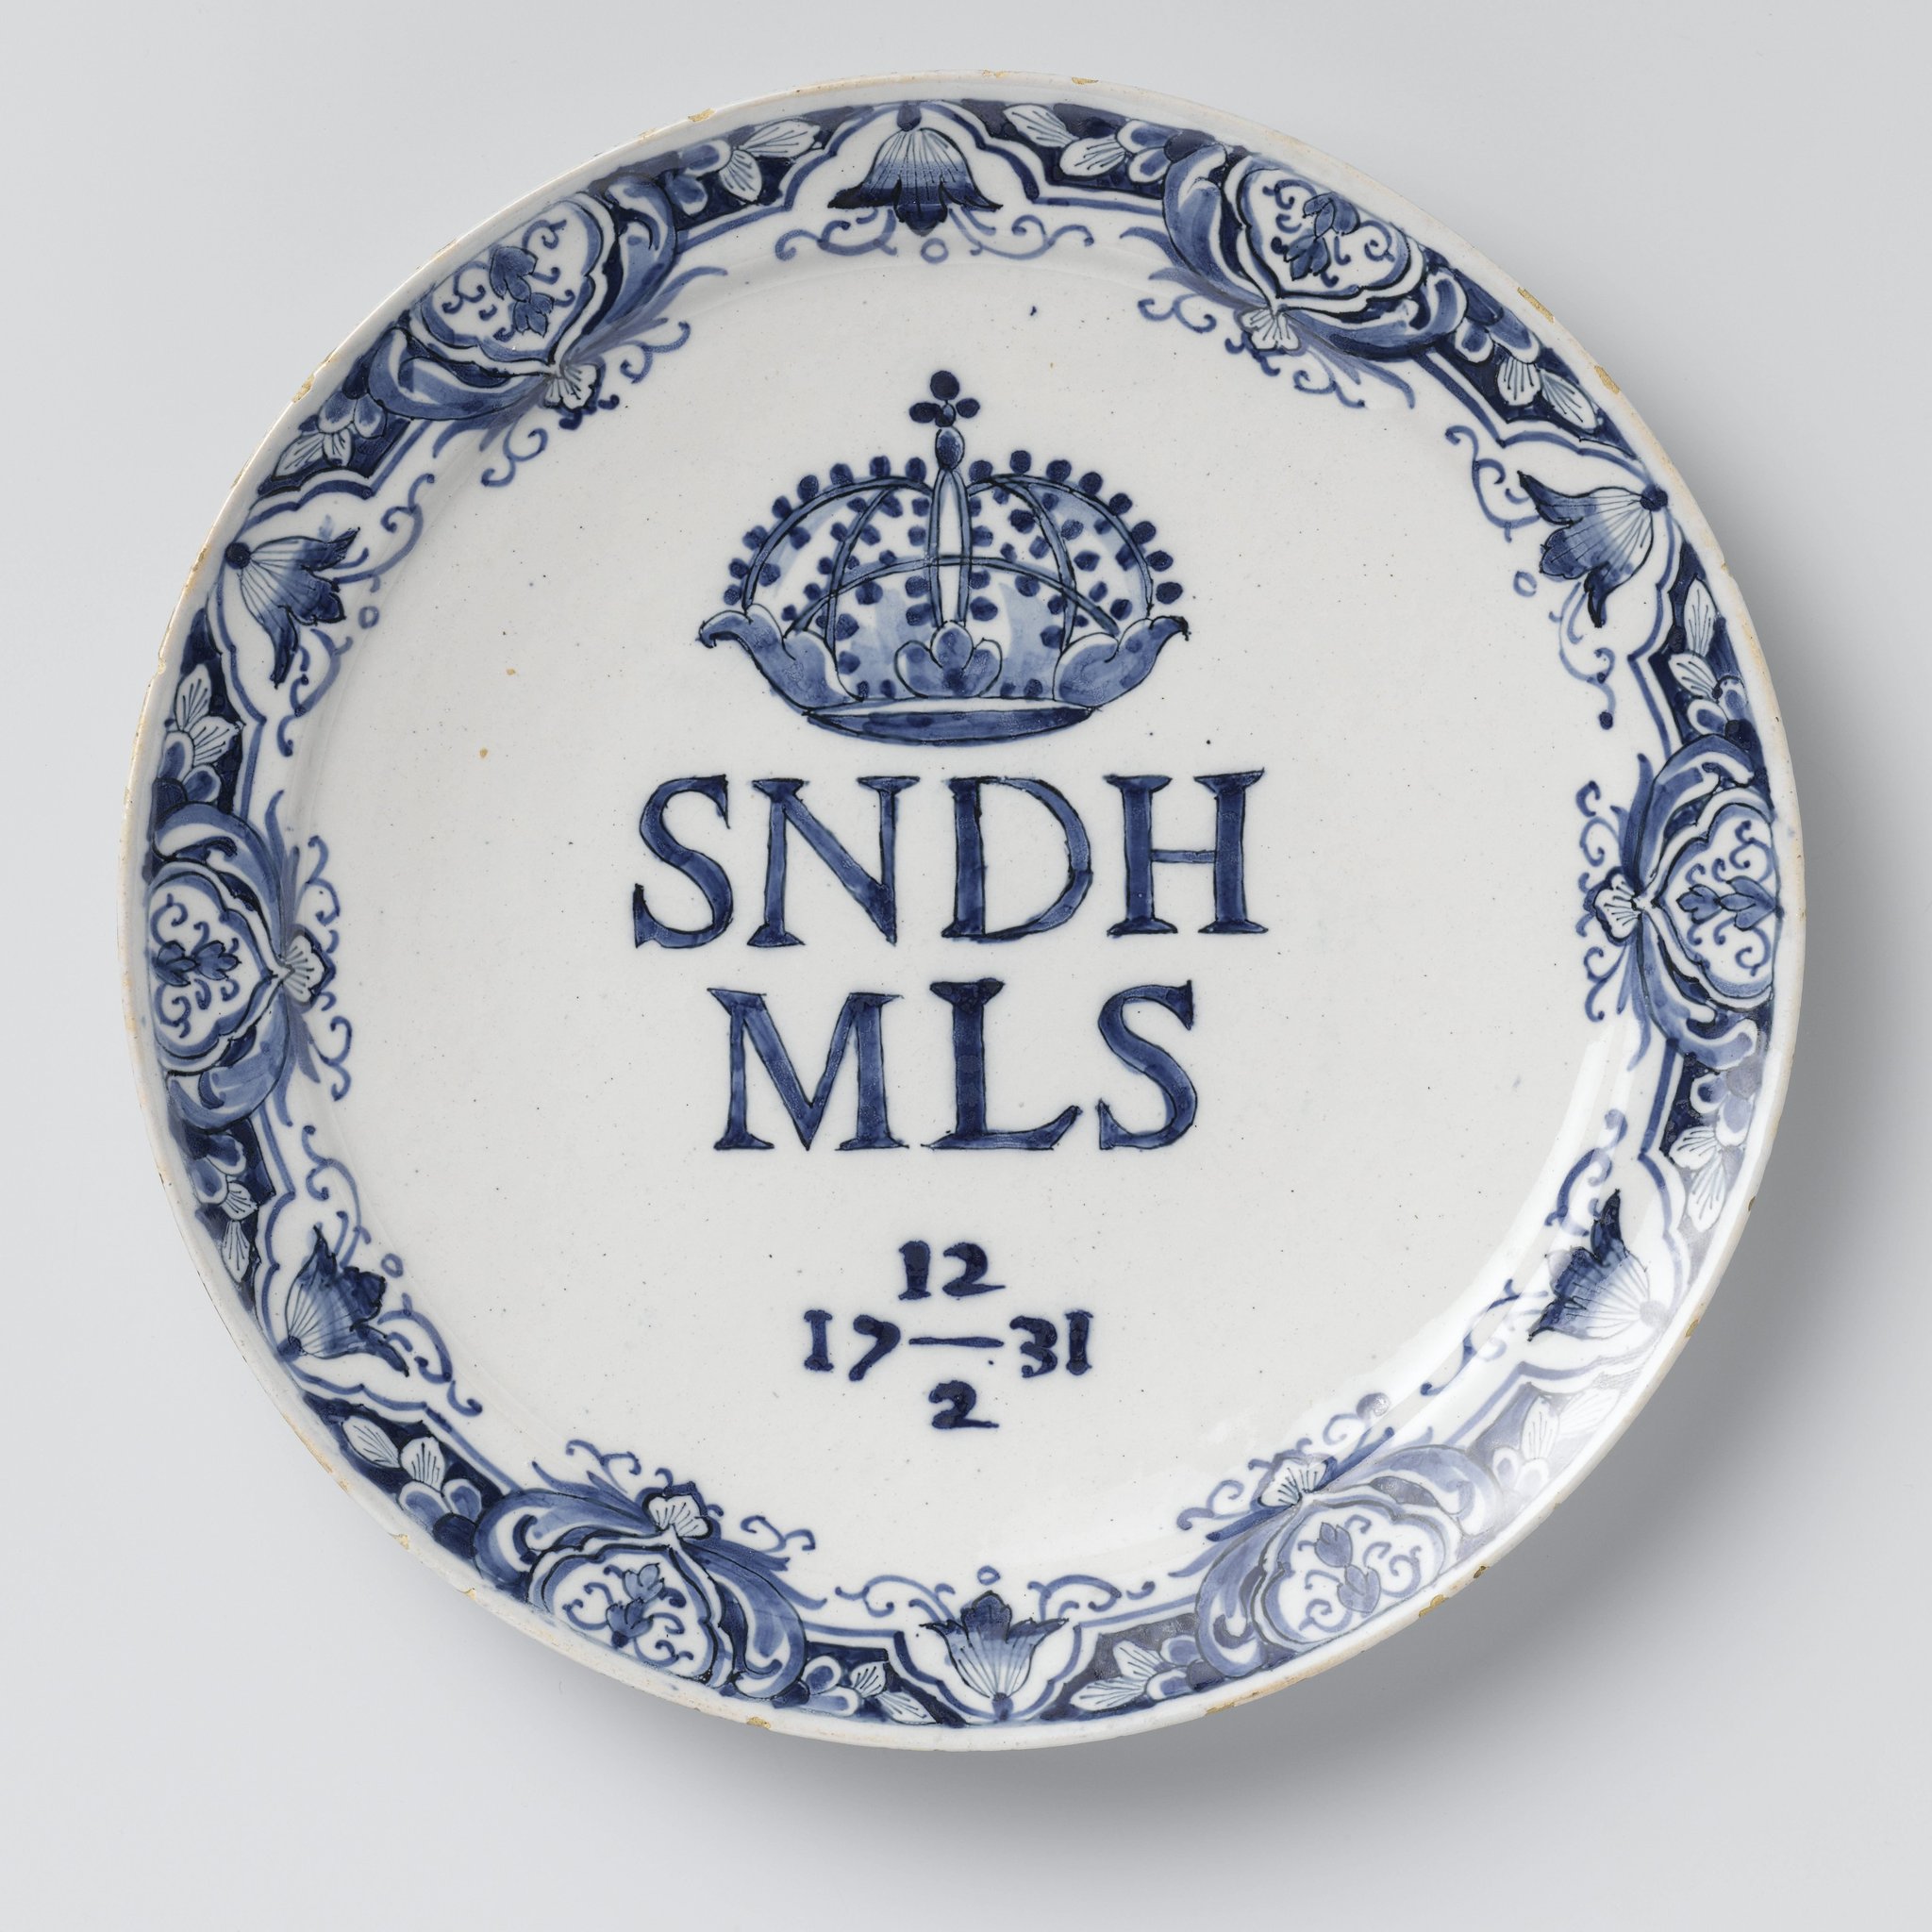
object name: plate dish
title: Bord, beschilderd met een twee onbekende monogrammen onder een kroon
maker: Anonymous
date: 1731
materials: earthenware, glaze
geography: delft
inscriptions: inscription: ‘MVB(ineen)’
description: Bord van faience, beschilder in blauw met twee onbekende monogrammen, SNDH en MLS, onder een gefantaseerde koningskroon.